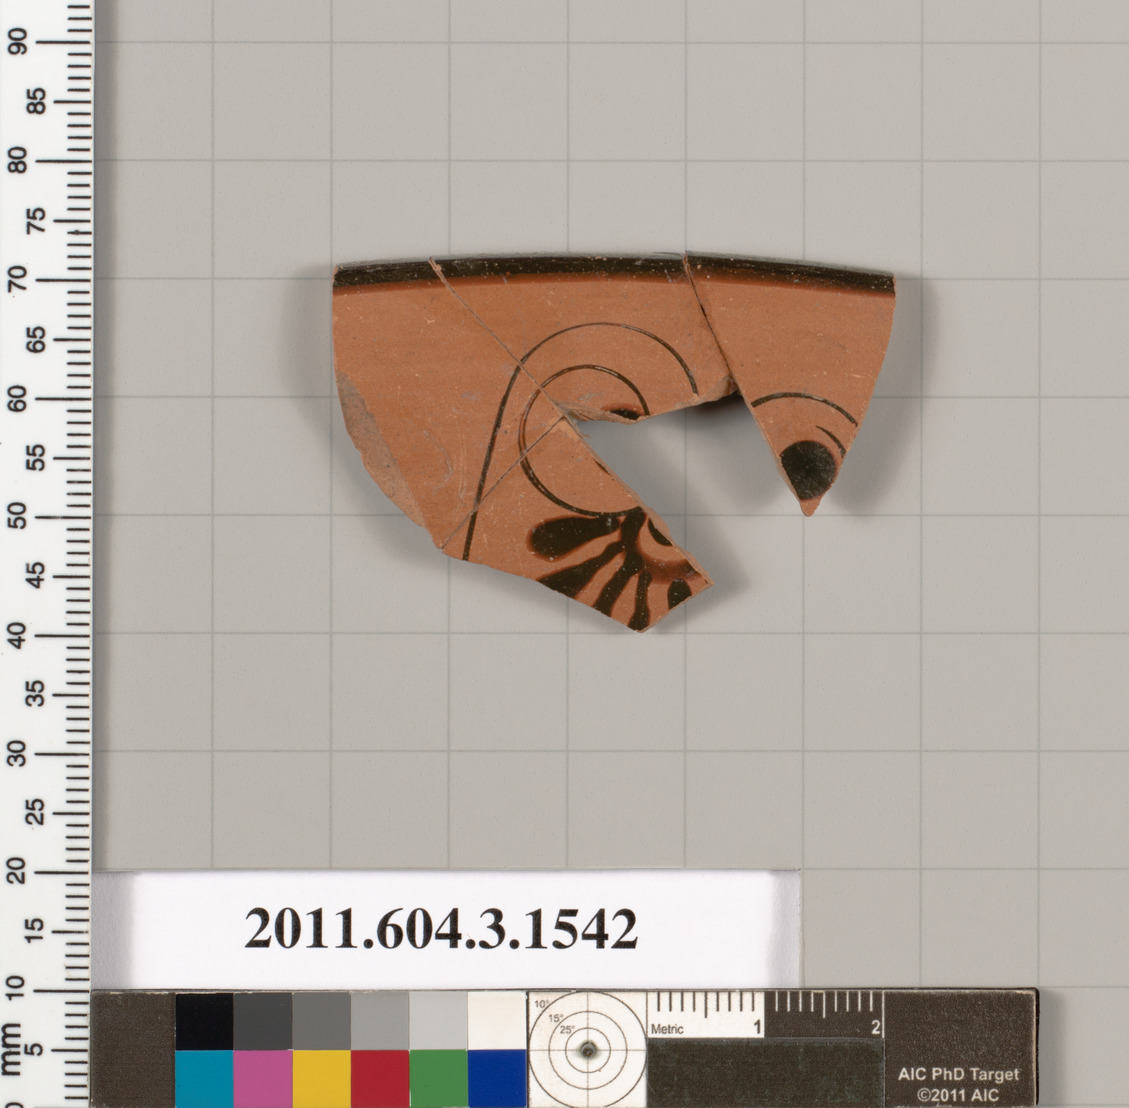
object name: kylix fragment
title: Terracotta rim fragment of a kylix (drinking cup)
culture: greek, attic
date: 550-526 BCE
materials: terracotta